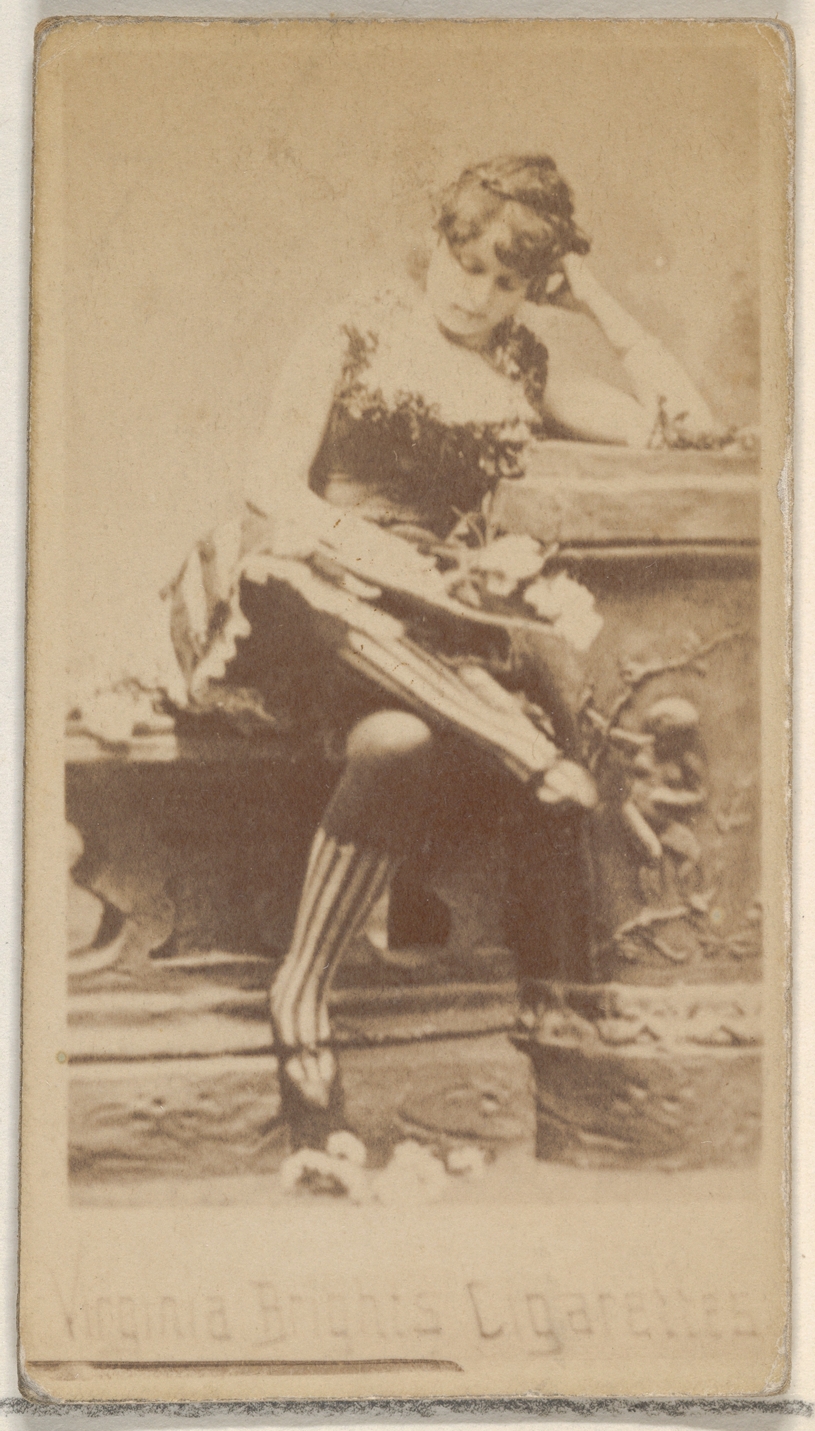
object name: photograph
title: From the Actors and Actresses series (N45, Type 5) for Virginia Brights Cigarettes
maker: allen & ginter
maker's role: publisher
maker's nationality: american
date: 1888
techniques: albumen silver print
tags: portraits,women,actresses